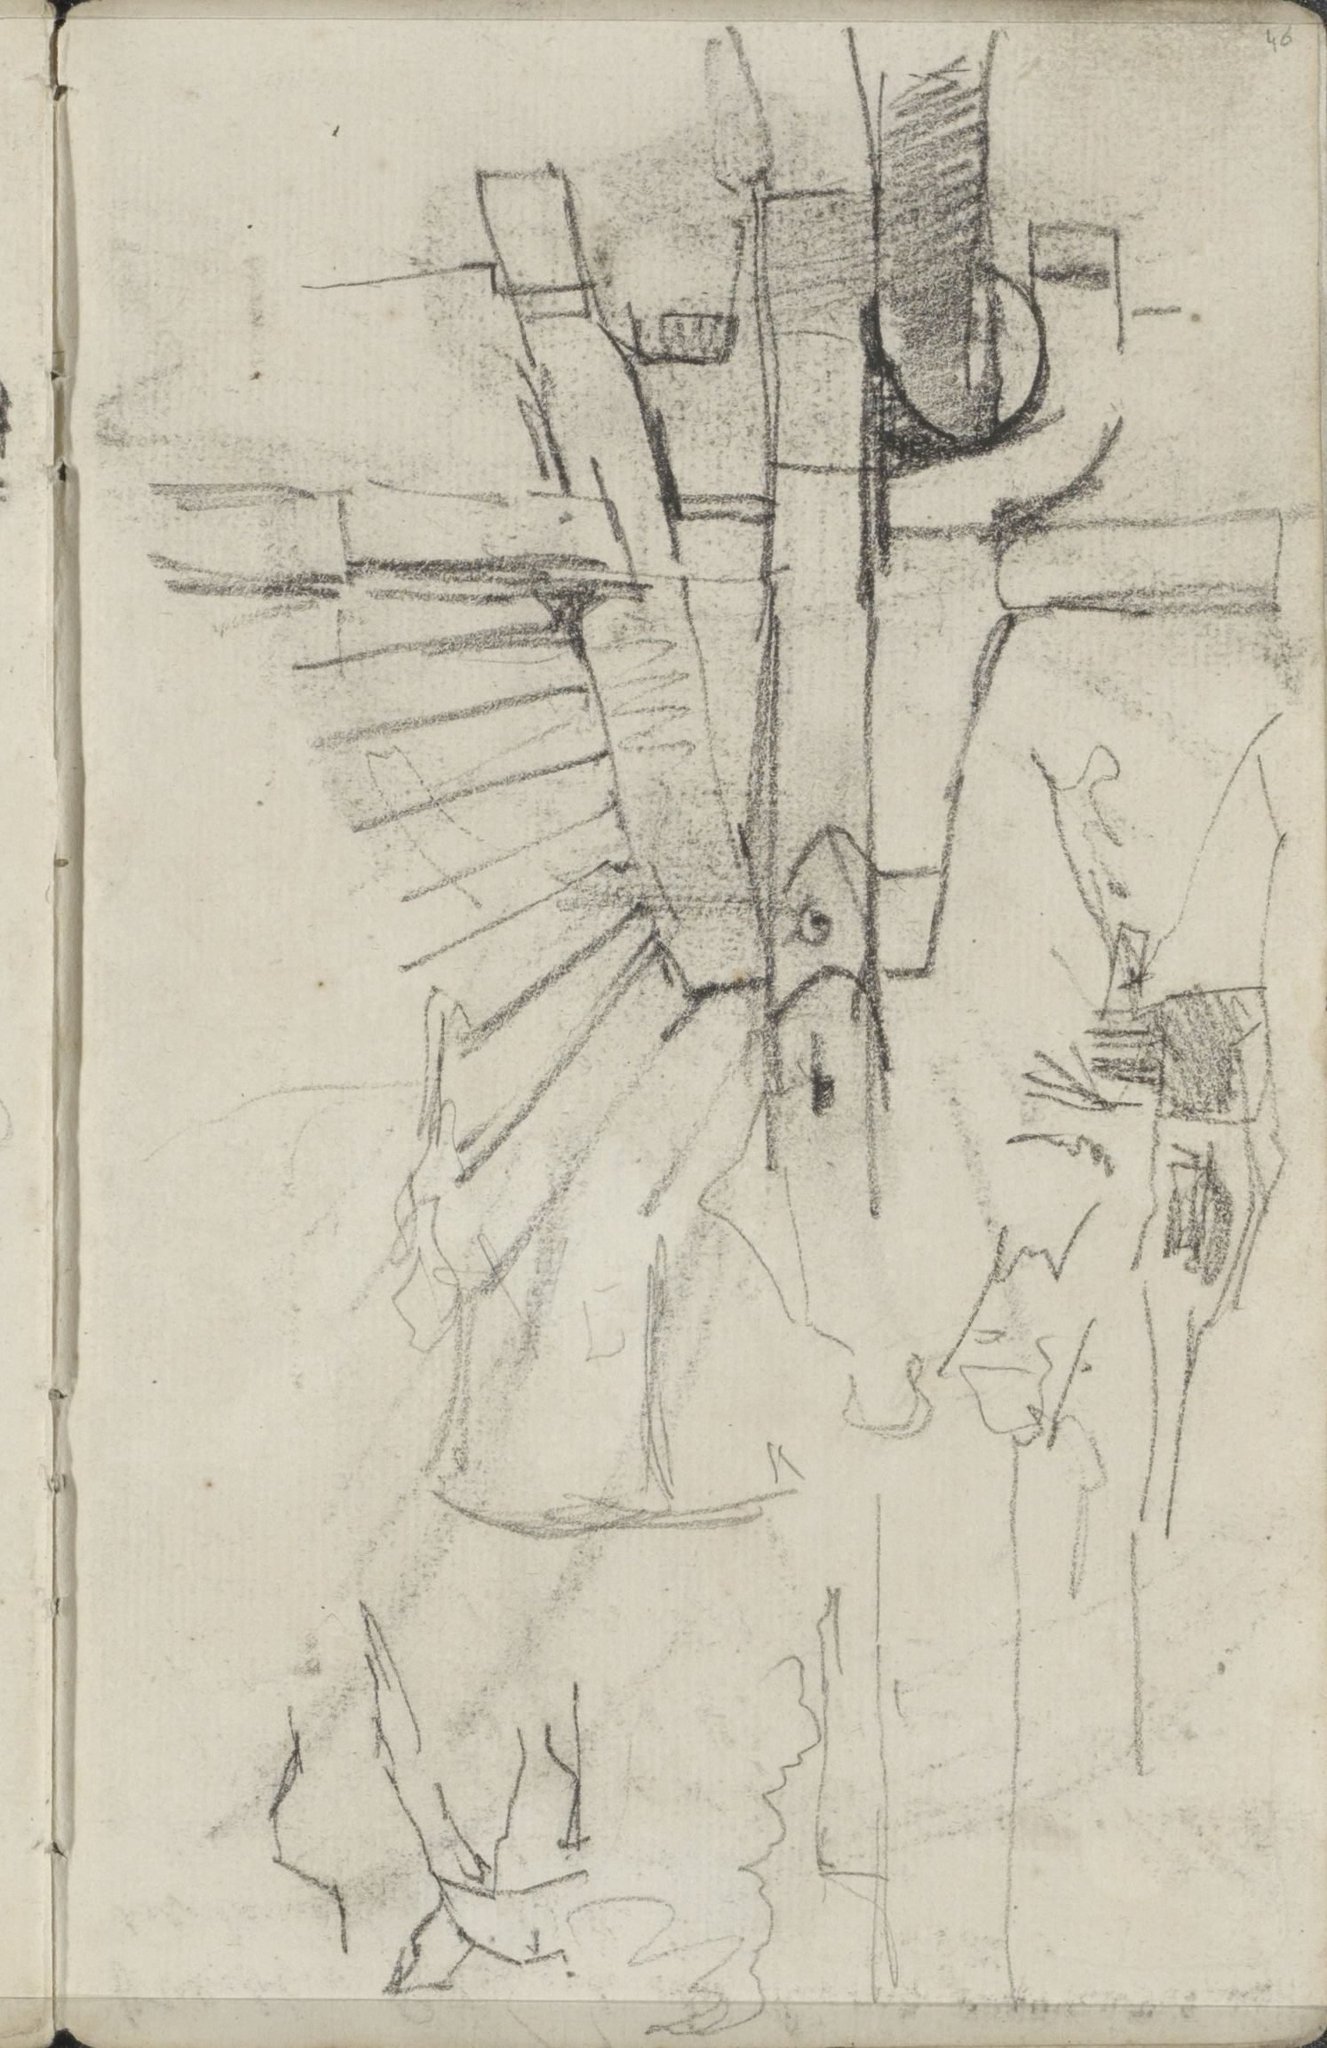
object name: sketchbook leaf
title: Studieblad, mogelijk met een bootonderdeel en een landschap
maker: george hendrik breitner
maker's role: draughtsman, painter, print maker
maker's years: 1857-1923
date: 1880-1882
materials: chalk, paper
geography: the hague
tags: landscapes, ships (in general)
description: Pagina 46 uit een schetsboek met 23 bladen.